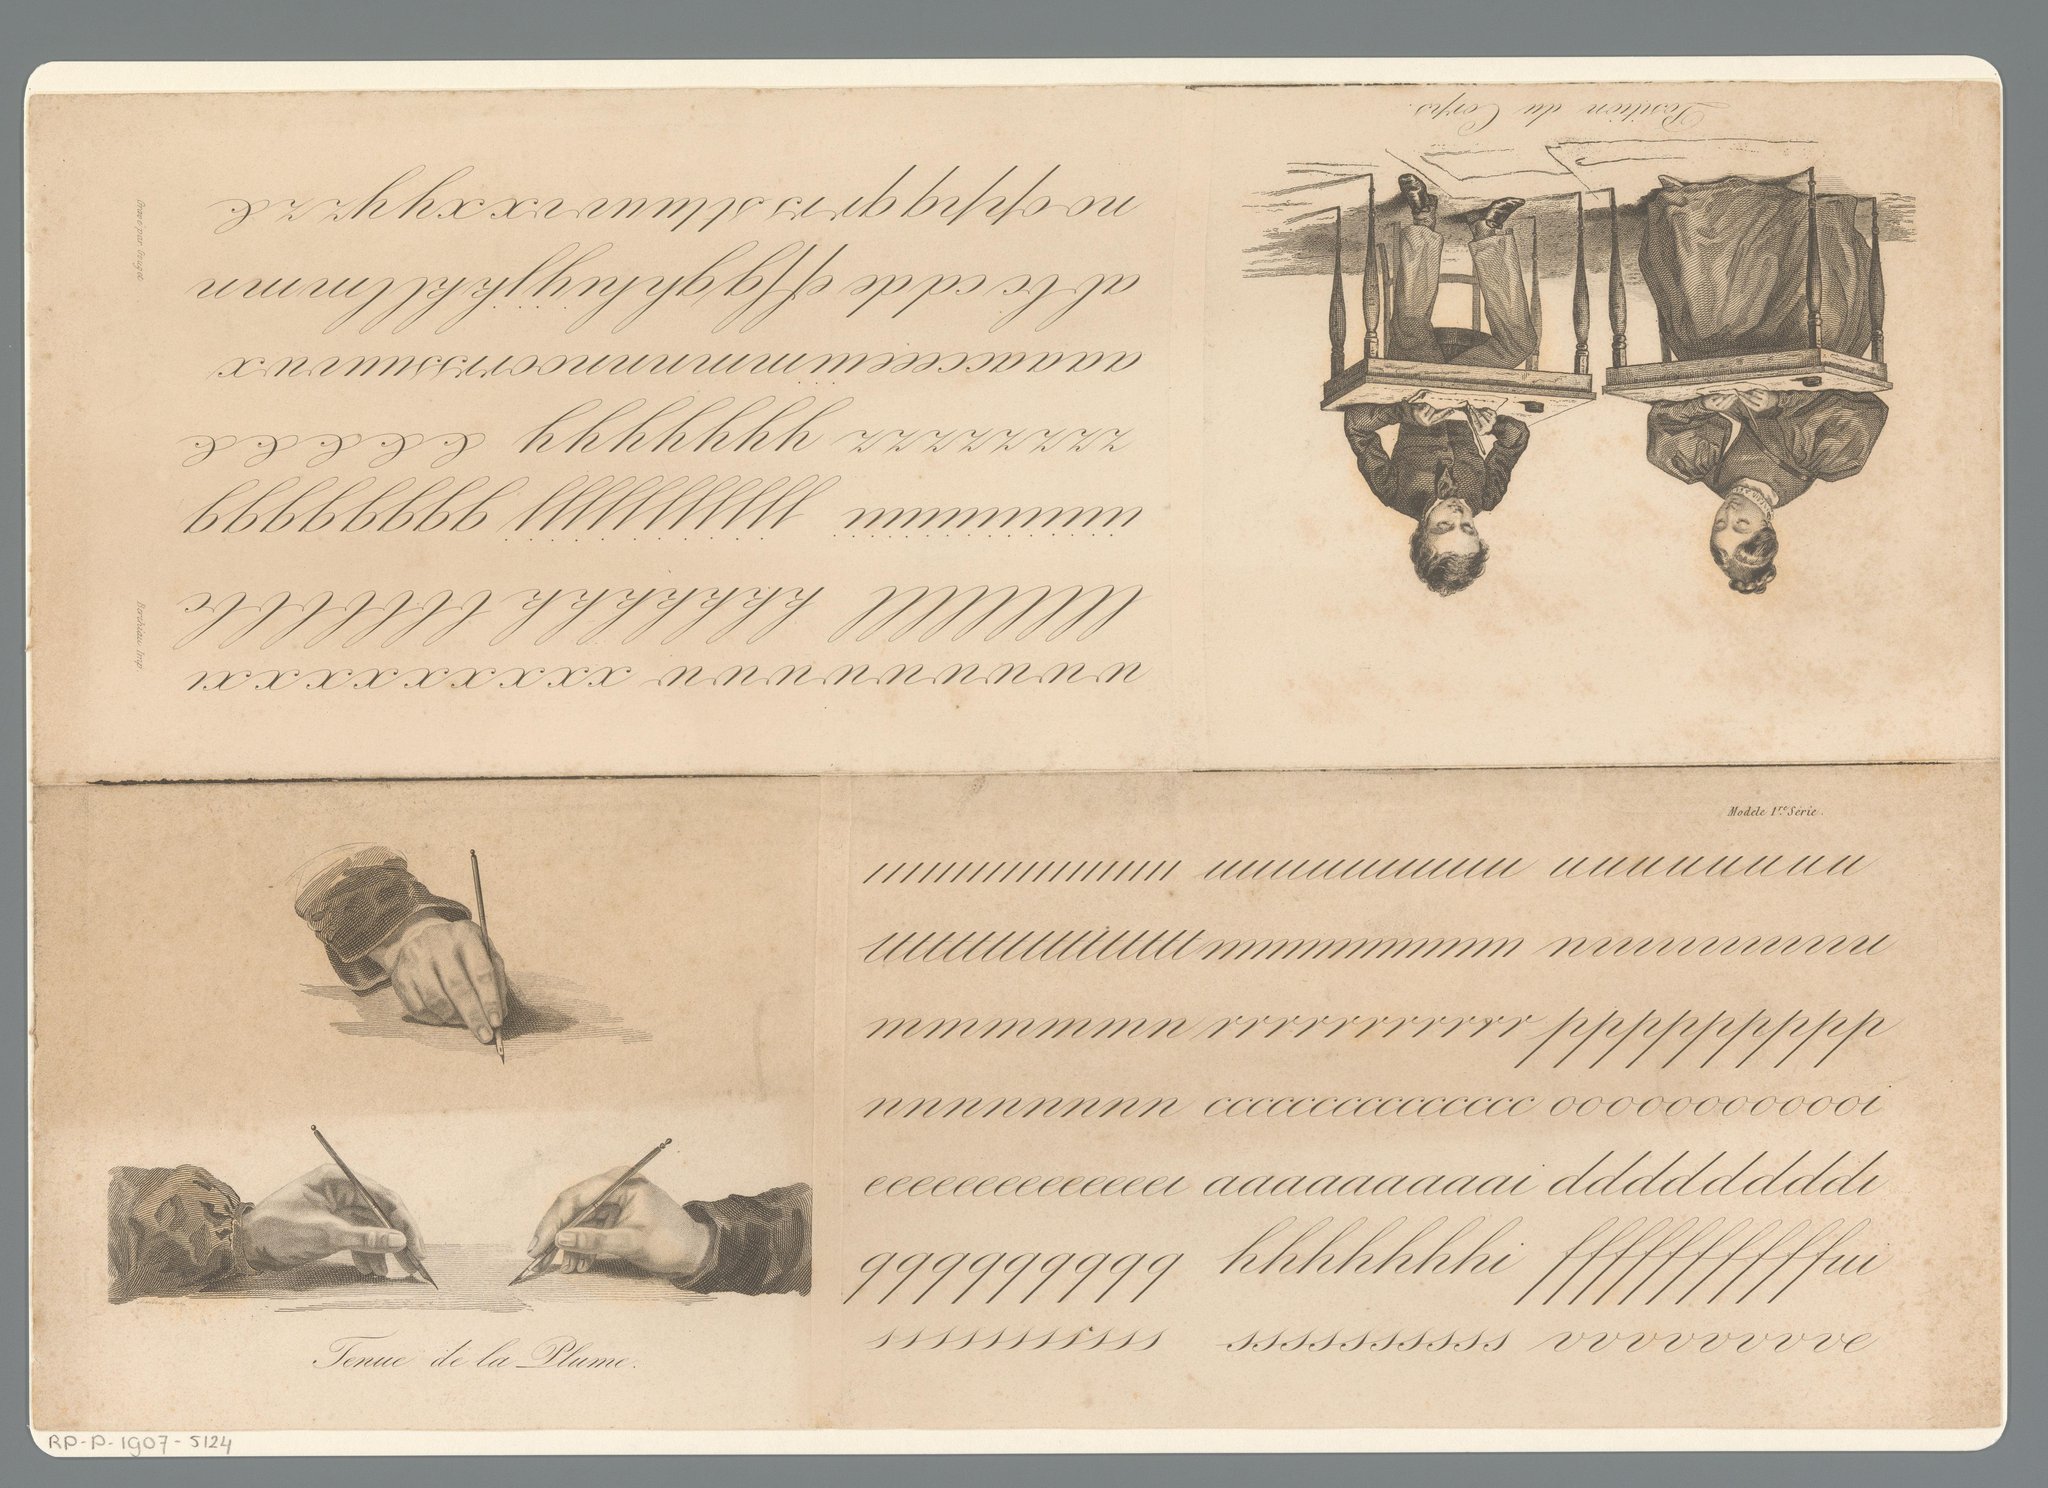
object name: ornament print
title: Recueil de planches d’apprentissage d’écriture pour enfants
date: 1840-1860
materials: paper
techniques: engraving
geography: france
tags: letters, alphabet, script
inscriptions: collector's mark: Lugt 2228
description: Schrijfvoorbeelden van verschillende letters. Links daarvan voorbeelden van een goede schrijfhouding en de juist manier om een pen vast te houden; een jongen en meisje zitten aan tafel en drie aanzichten van een schrijvende hand met pen. Rechts midden vermeld: Modele 1re Serie.